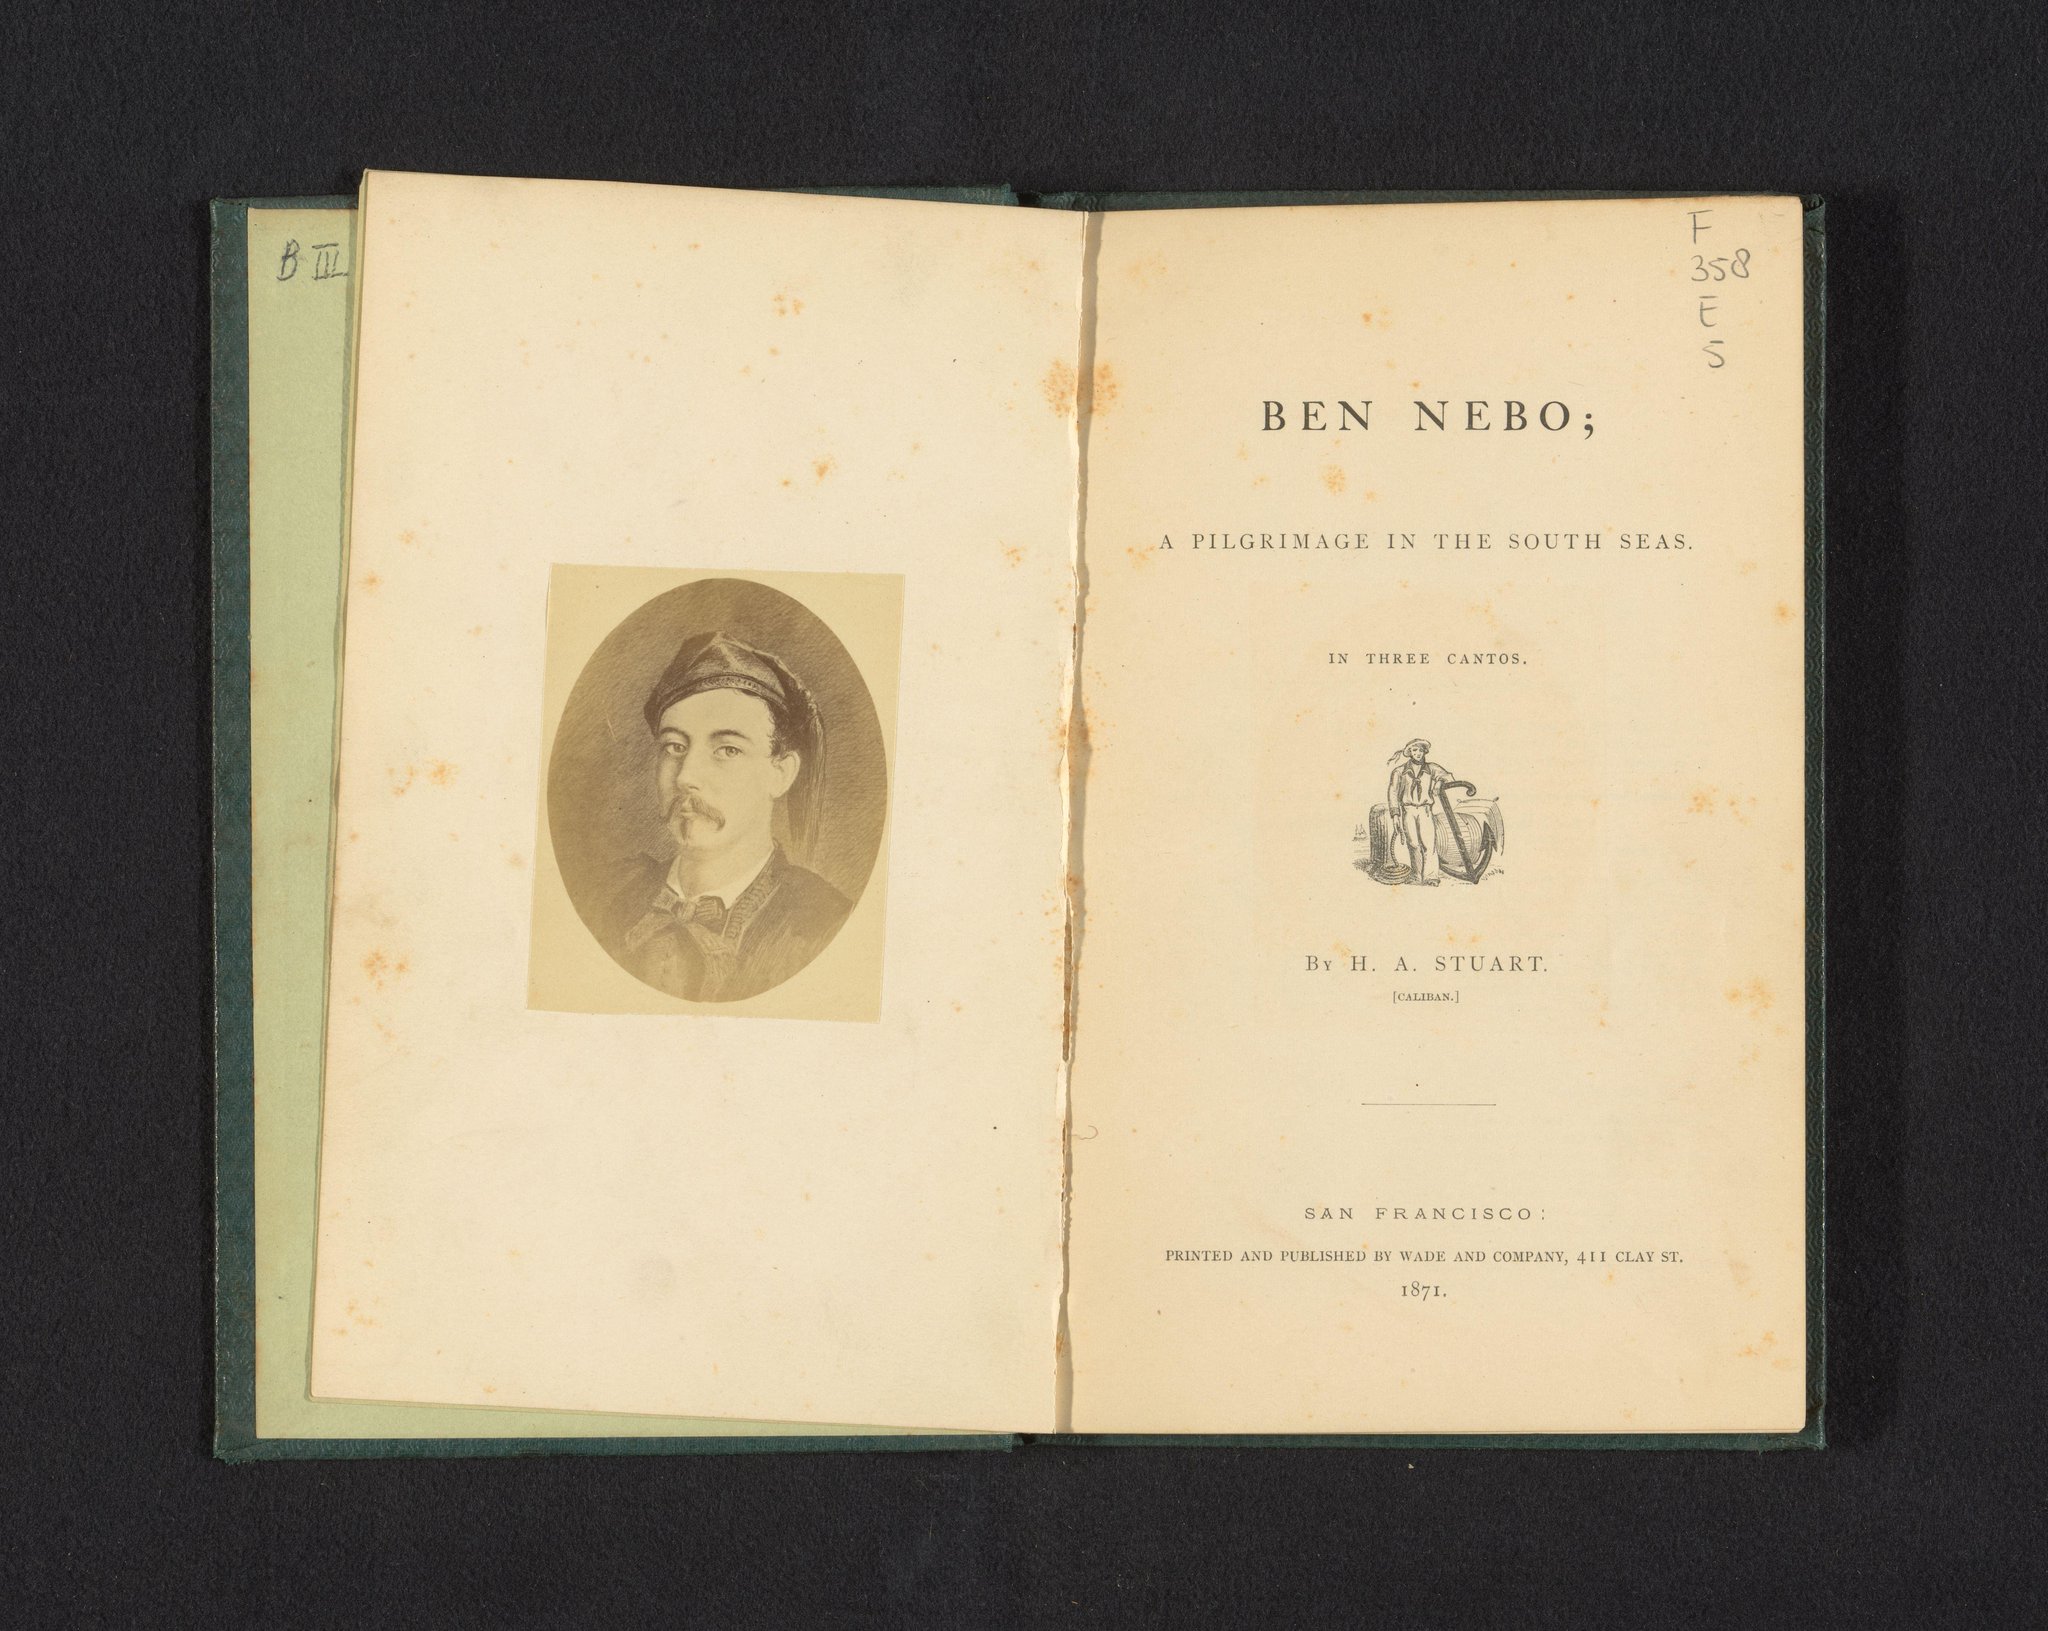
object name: book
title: Ben Nebo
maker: hector a. stuart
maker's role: schrijver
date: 1871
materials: cardboard, linen, paper, photographic support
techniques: albumen print, printing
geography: san francisco